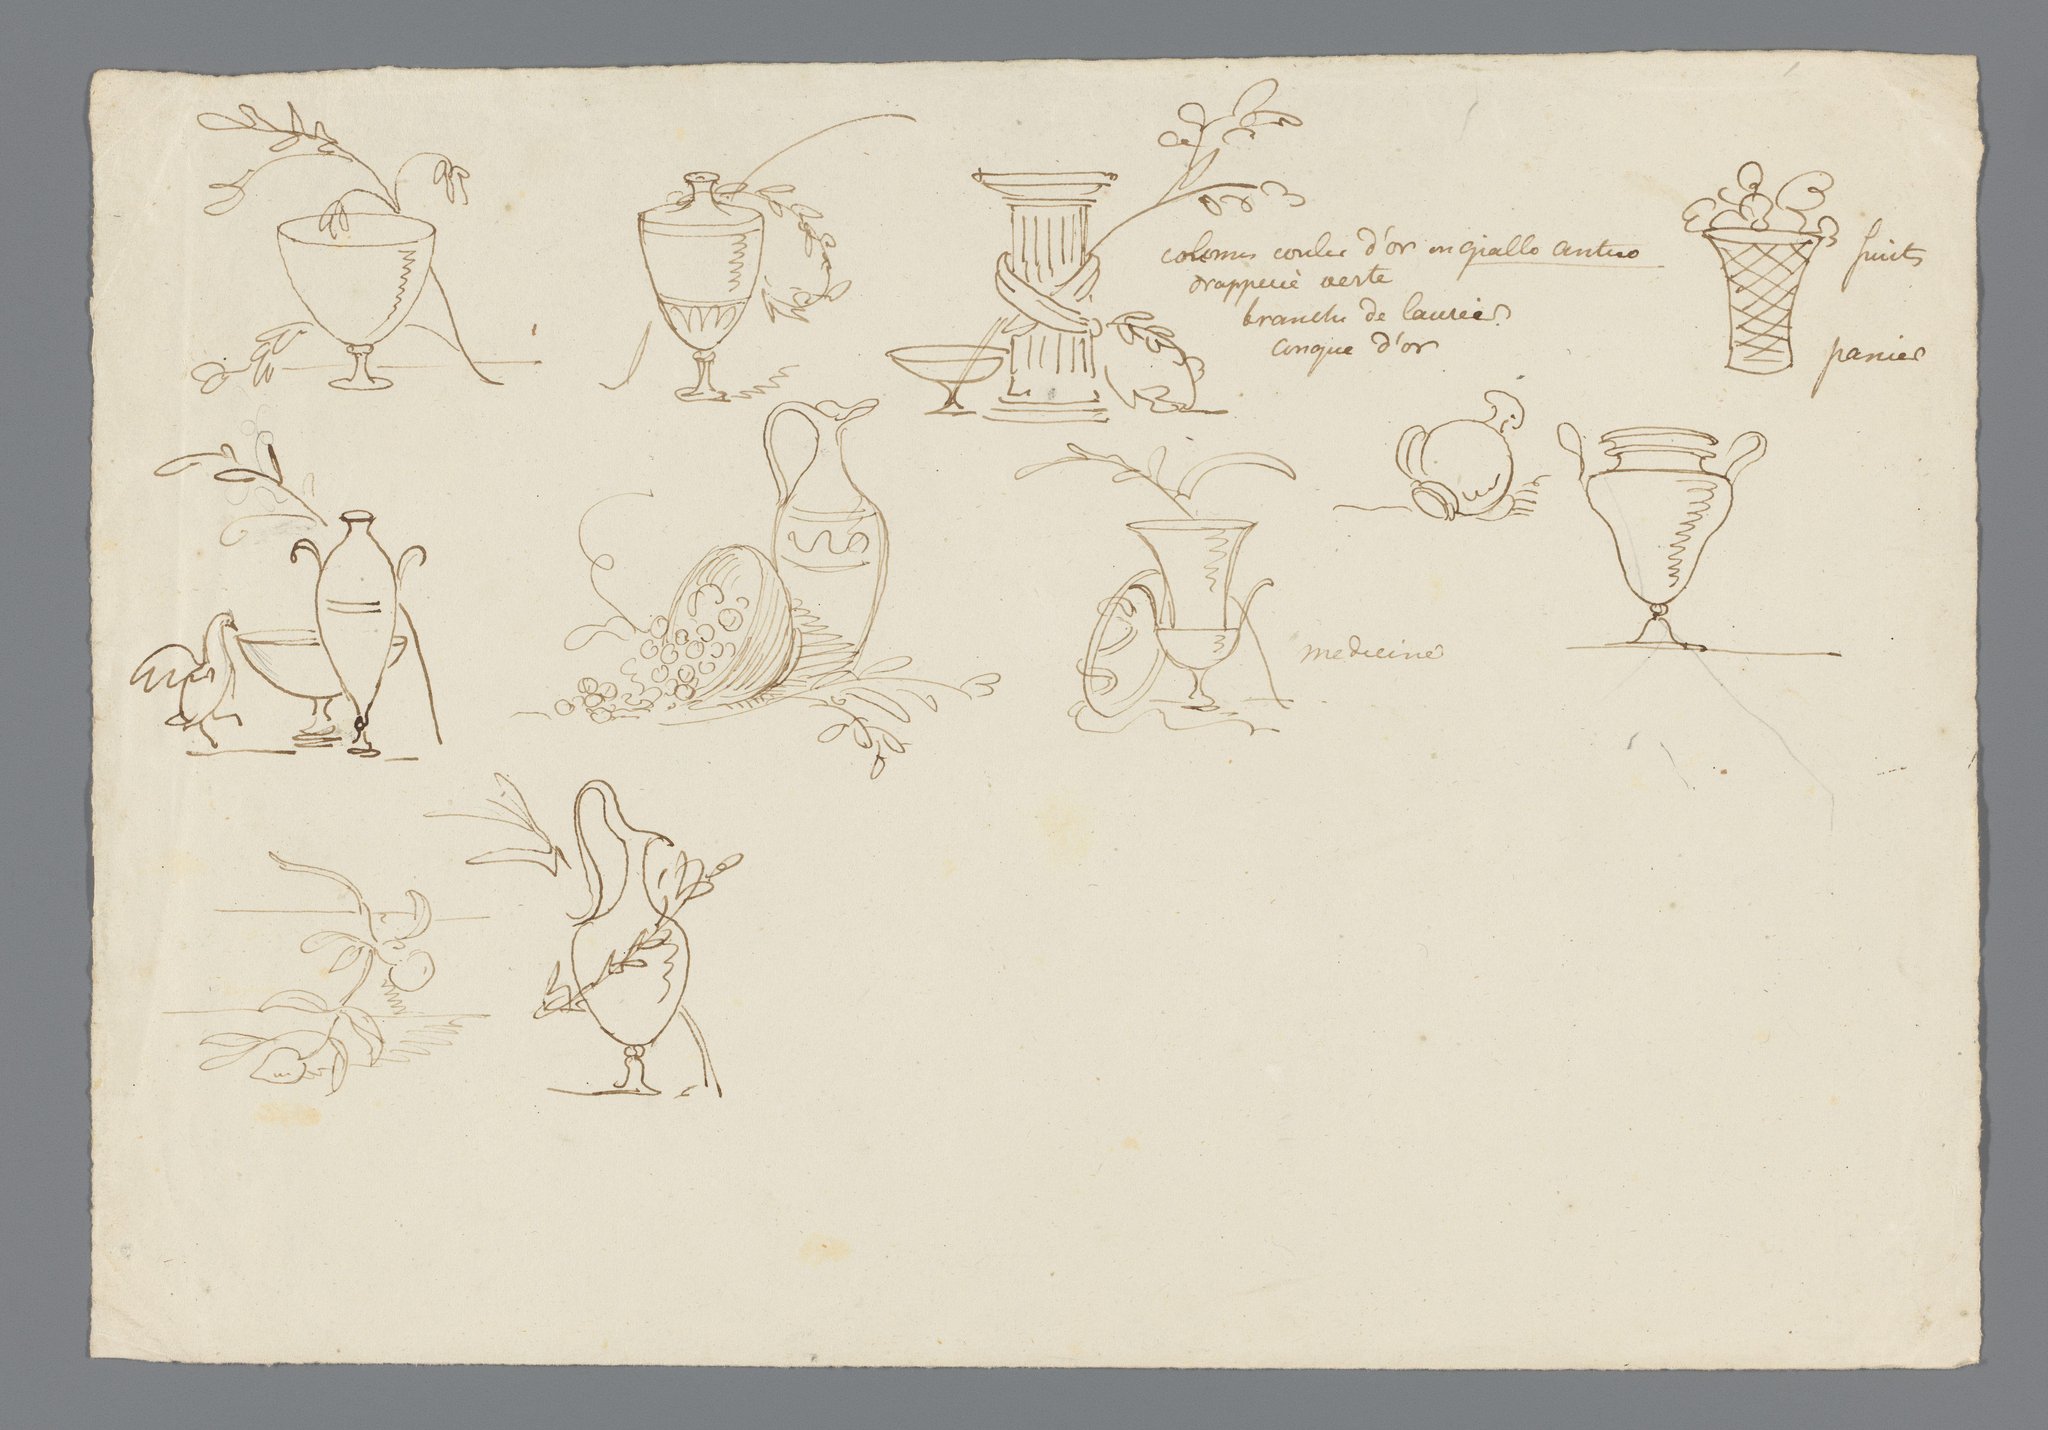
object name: drawing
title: Modeltekeningen van vazen en kannen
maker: david pièrre giottino humbert de superville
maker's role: draughtsman, painter, print maker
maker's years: 1770-1849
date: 1780-1849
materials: ink, paper, pencil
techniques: pen